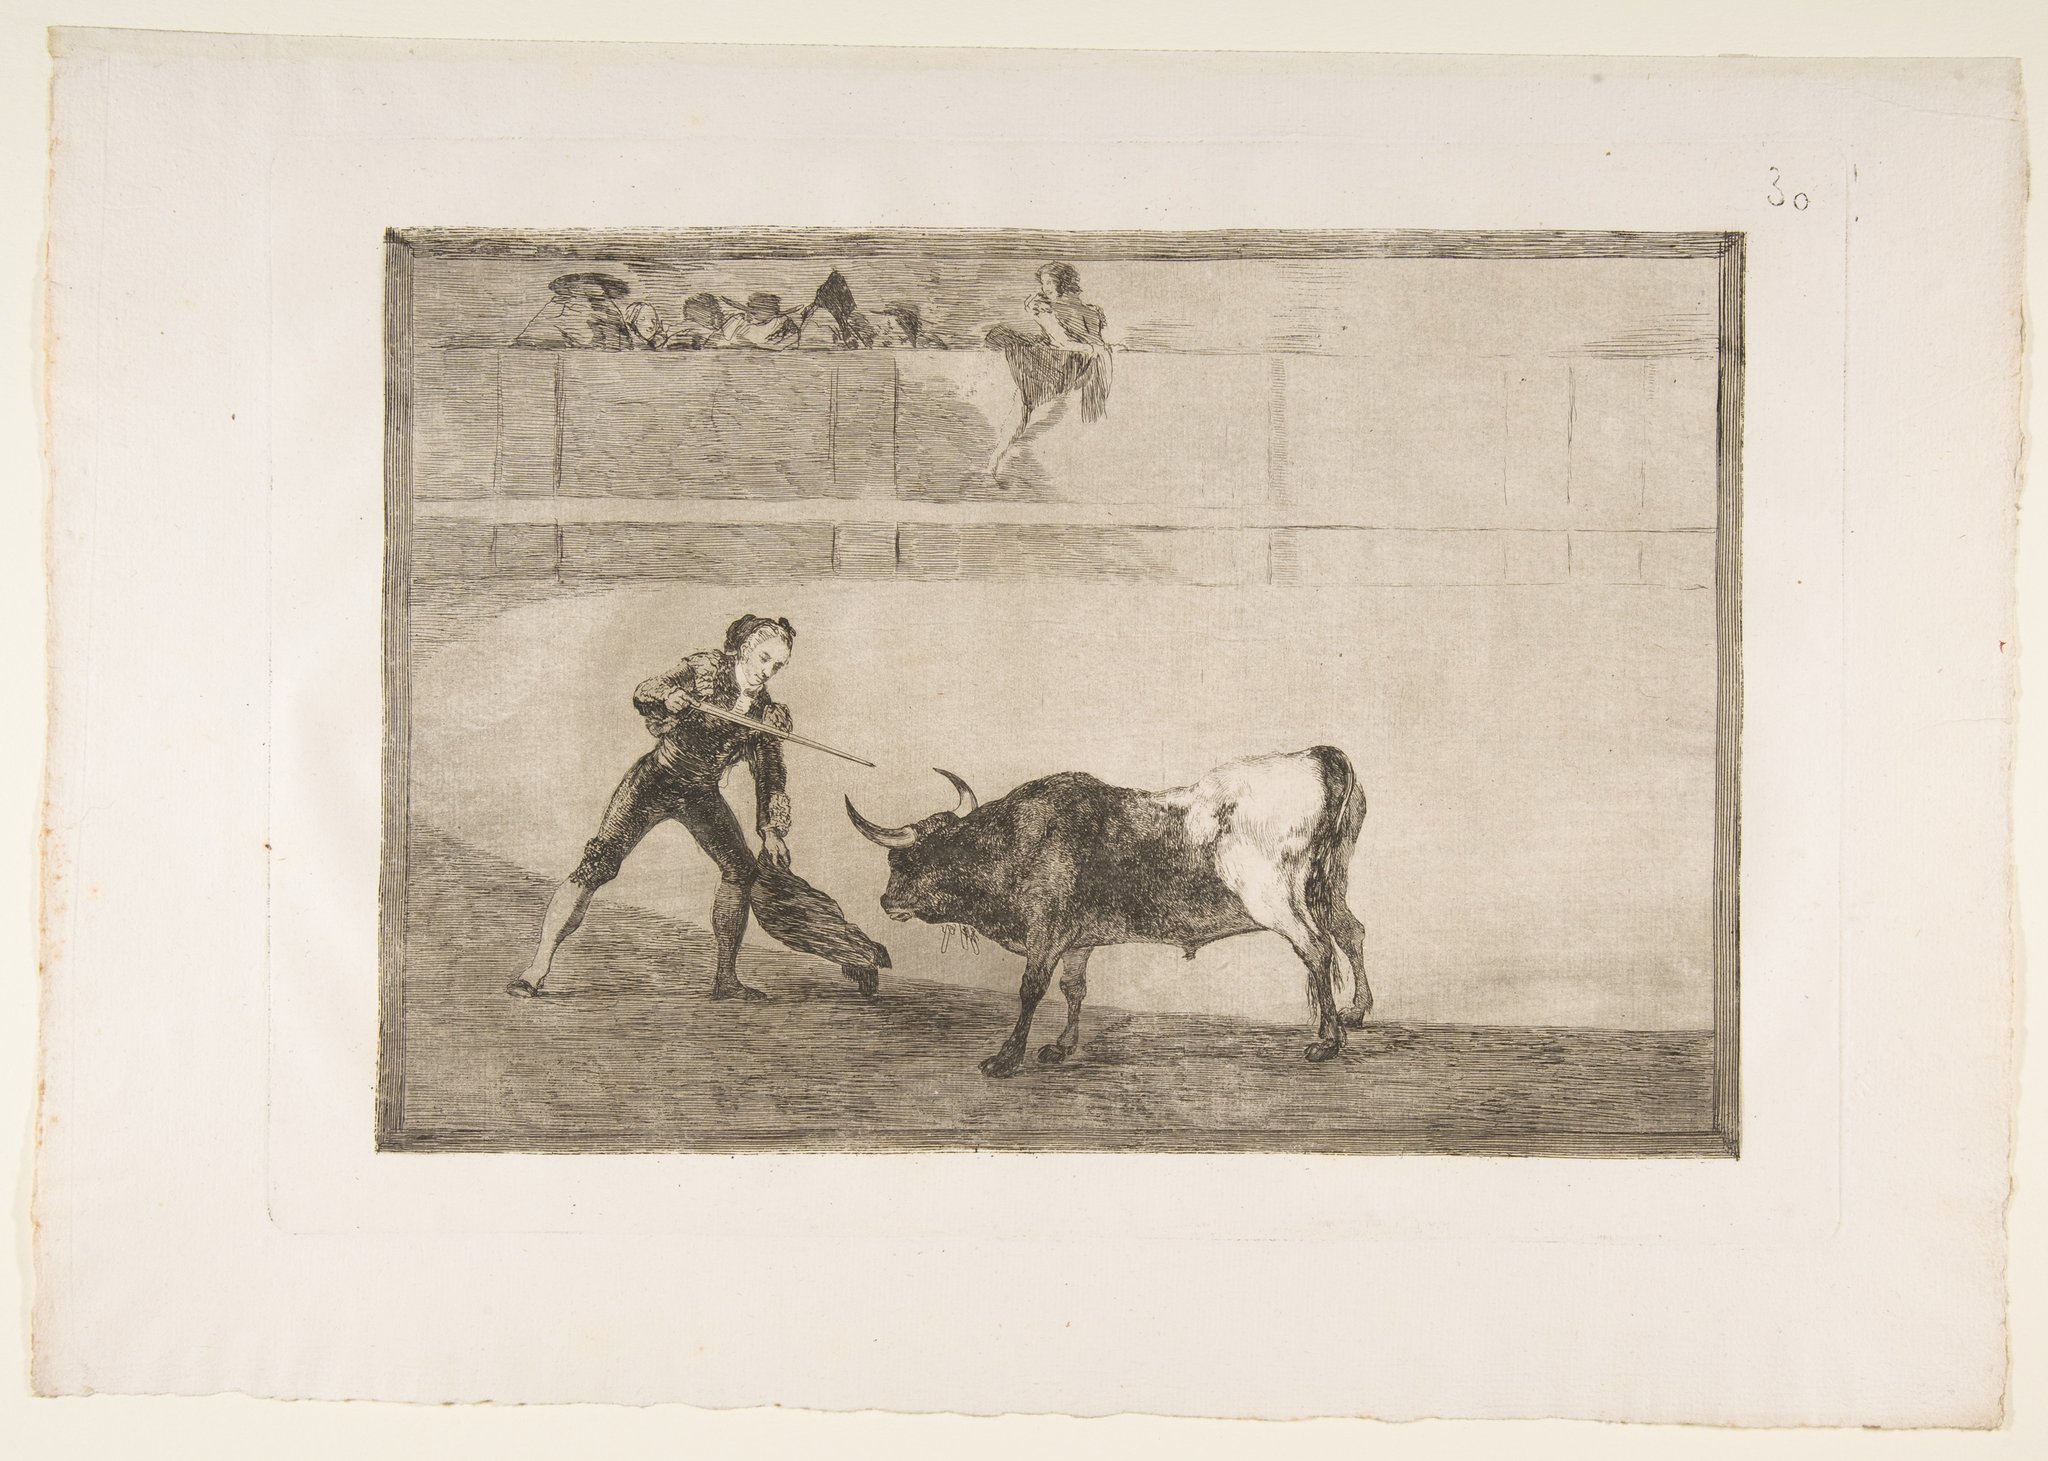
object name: print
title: Plate 30 from "La Tauromaquia": Pedro Romero killing the halted bull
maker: goya (francisco de goya y lucientes)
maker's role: artist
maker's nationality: spanish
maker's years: 1746-1828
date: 1816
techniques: aquatint, engraving, burnishing, etching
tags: men,bulls